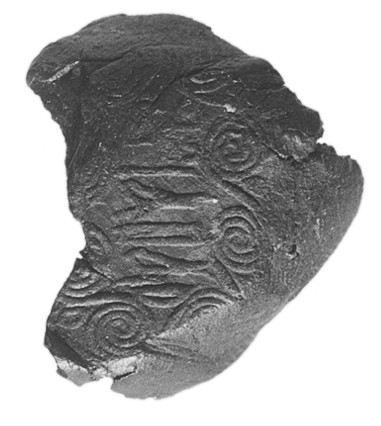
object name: sealing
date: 2030-1640 BCE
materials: clay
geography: egypt